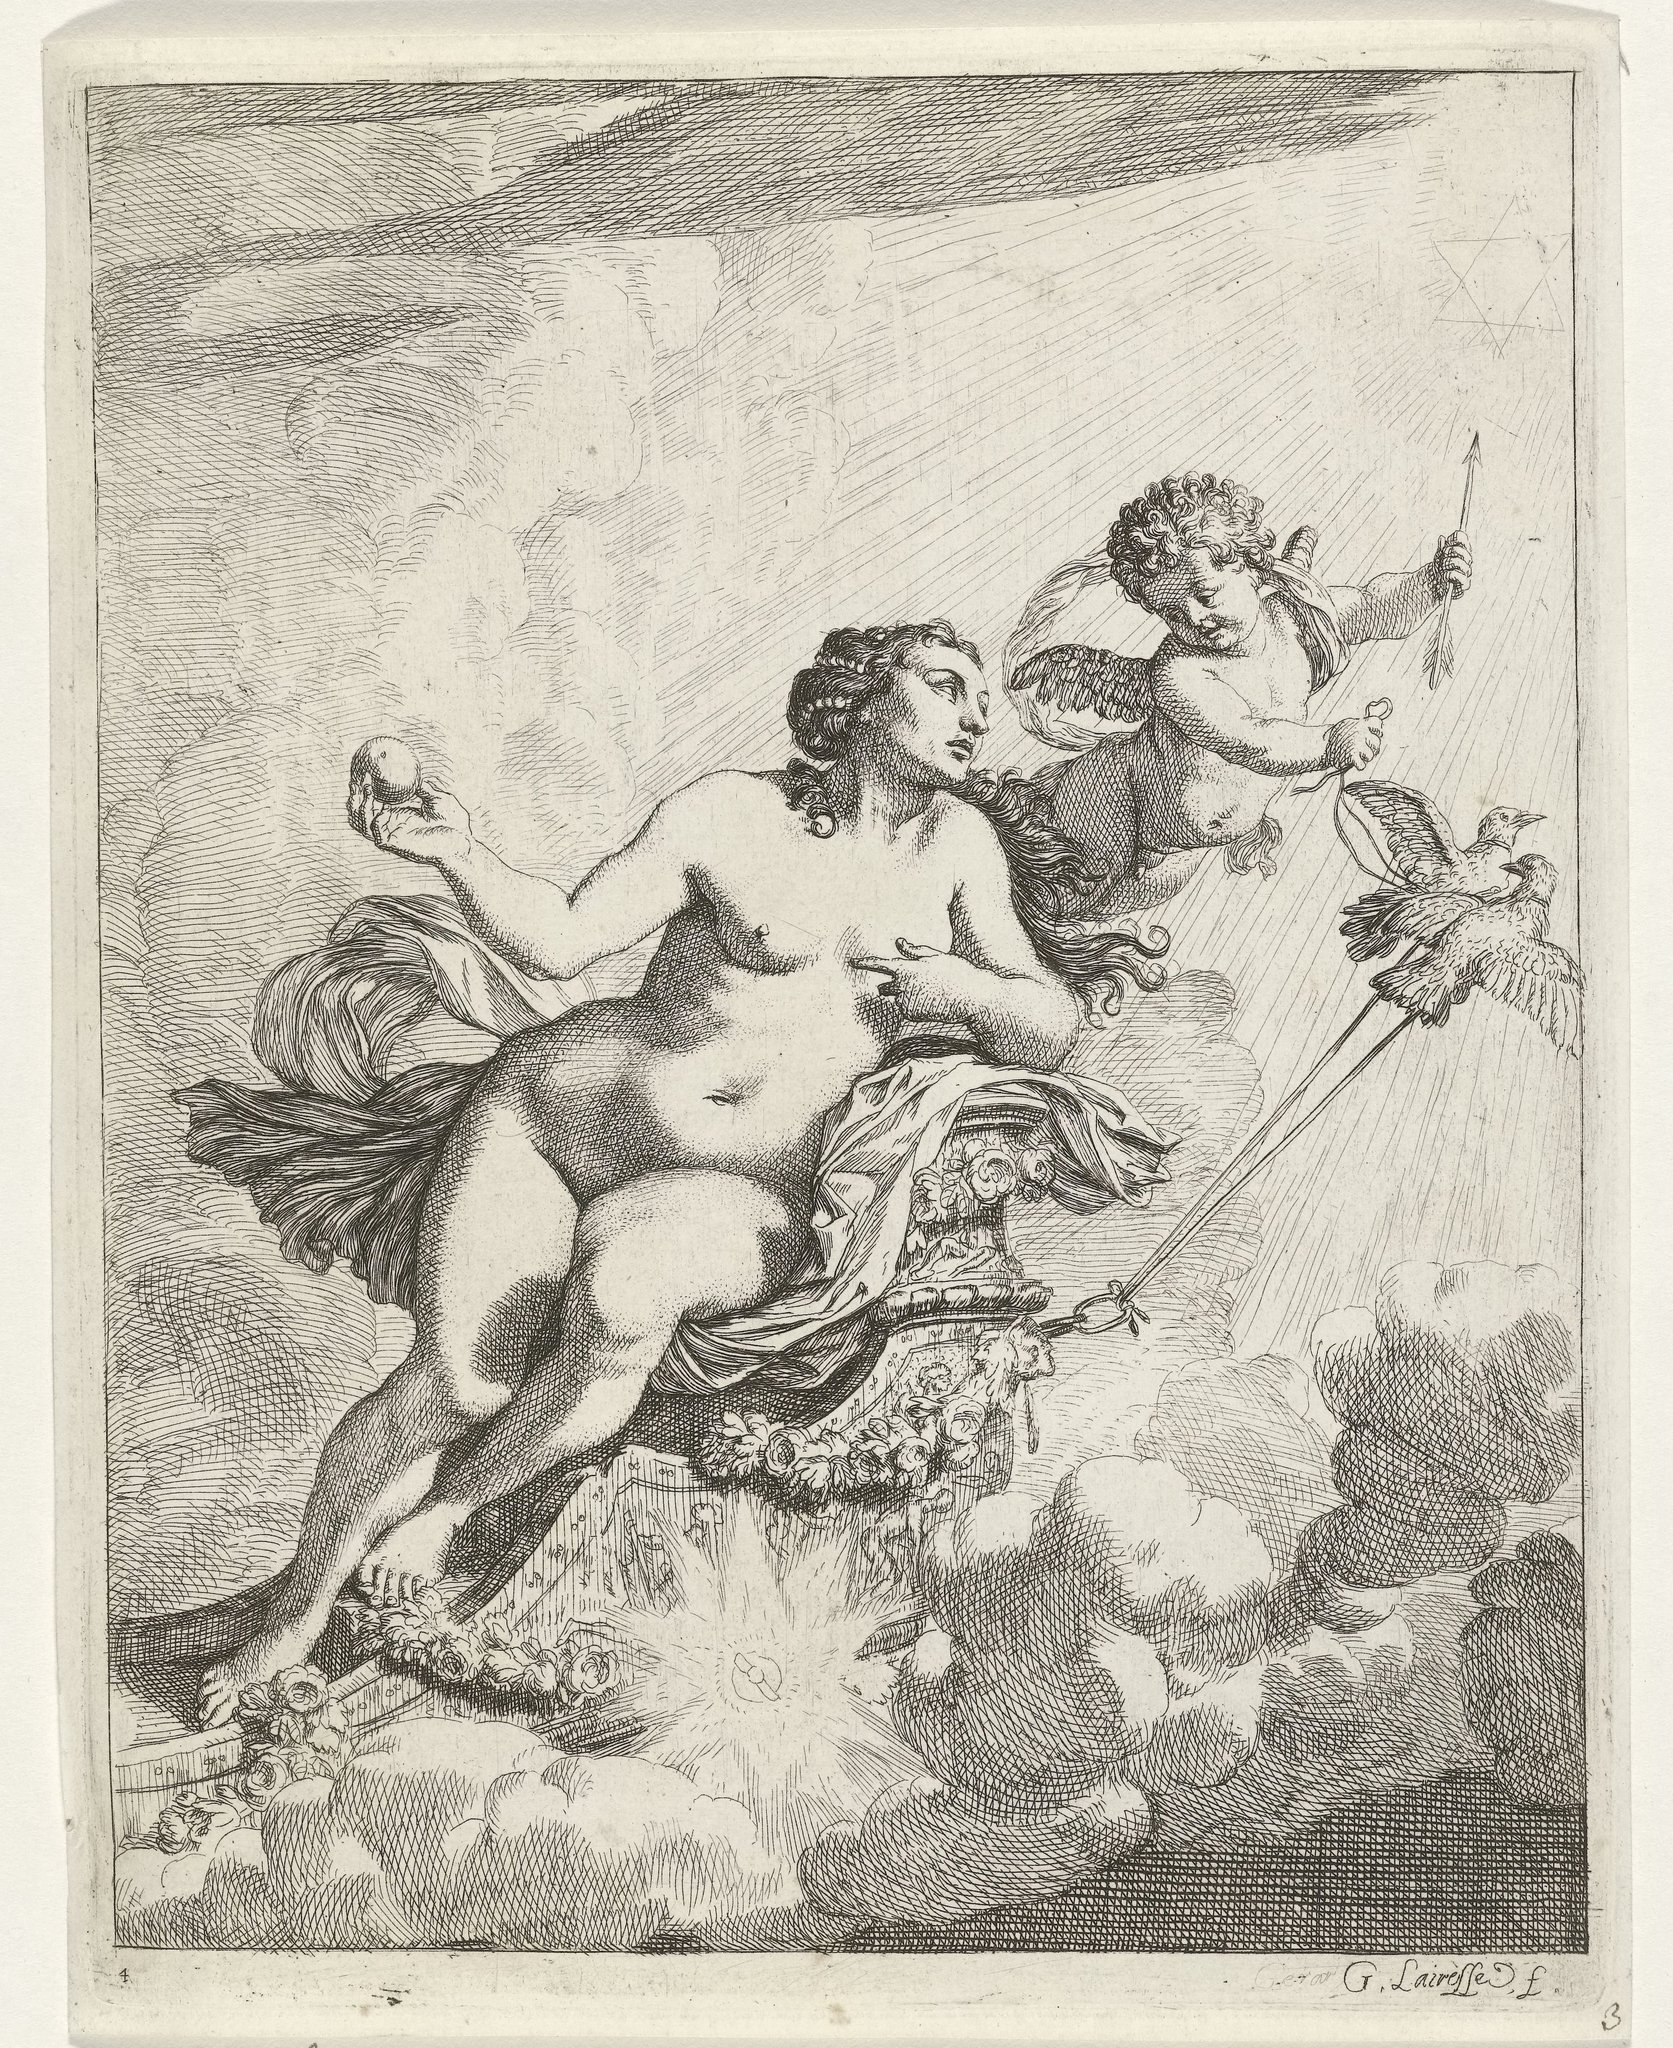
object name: print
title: Geschiedenis van Venus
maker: gerard de lairesse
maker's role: draughtsman, painter, print maker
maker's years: 1641-1711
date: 1675-1680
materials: paper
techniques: etching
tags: venus flees to olympus (because she has been wounded in the hand by diomedes)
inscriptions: collector's mark: Lugt 10, number: ‘3’, collector's mark: Lugt 11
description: Venus stijgt op haar zegekar voortgetrokken door duiven naar de Olympus en wordt hierbij vergezeld door Amor. De prent maakt deel uit van een vierdelige serie prenten met scènes uit het mythologische verhaal van Venus. Links in de marge genummerd: 4.